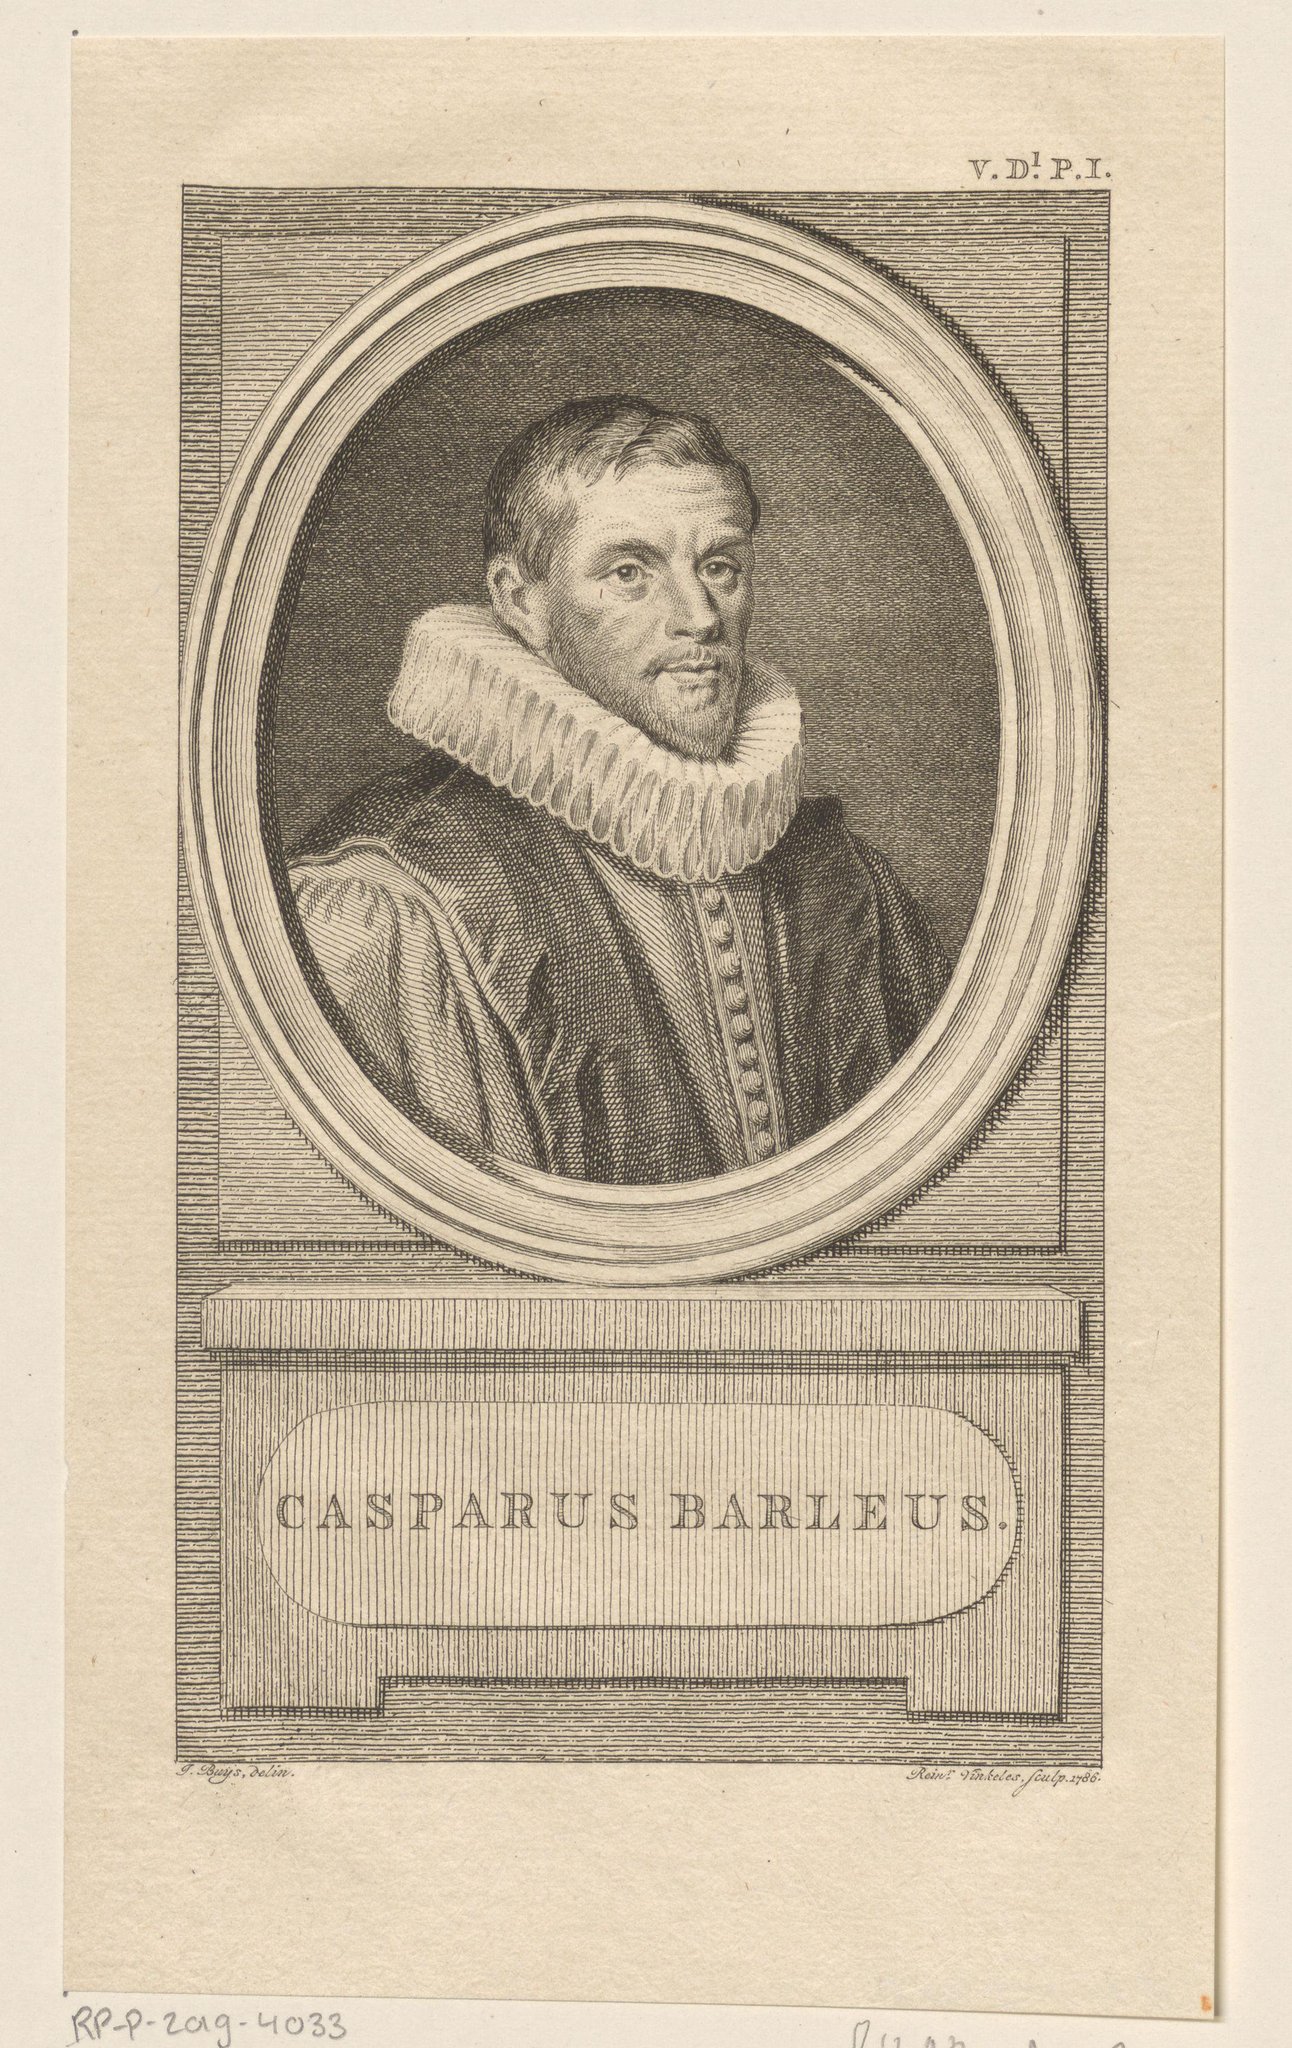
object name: print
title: Portret van Caspar van Baerle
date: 1786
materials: paper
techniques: engraving, etching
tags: antwerp, amsterdam, caspar van baerle, historical persons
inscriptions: date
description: Prent uit: Kok, Jacobus. Vaderlandsch woordenboek: met kaarten, plaaten en pourtraitten. Amsterdam: Johannes Allart, 1785-1796, dl. 5.